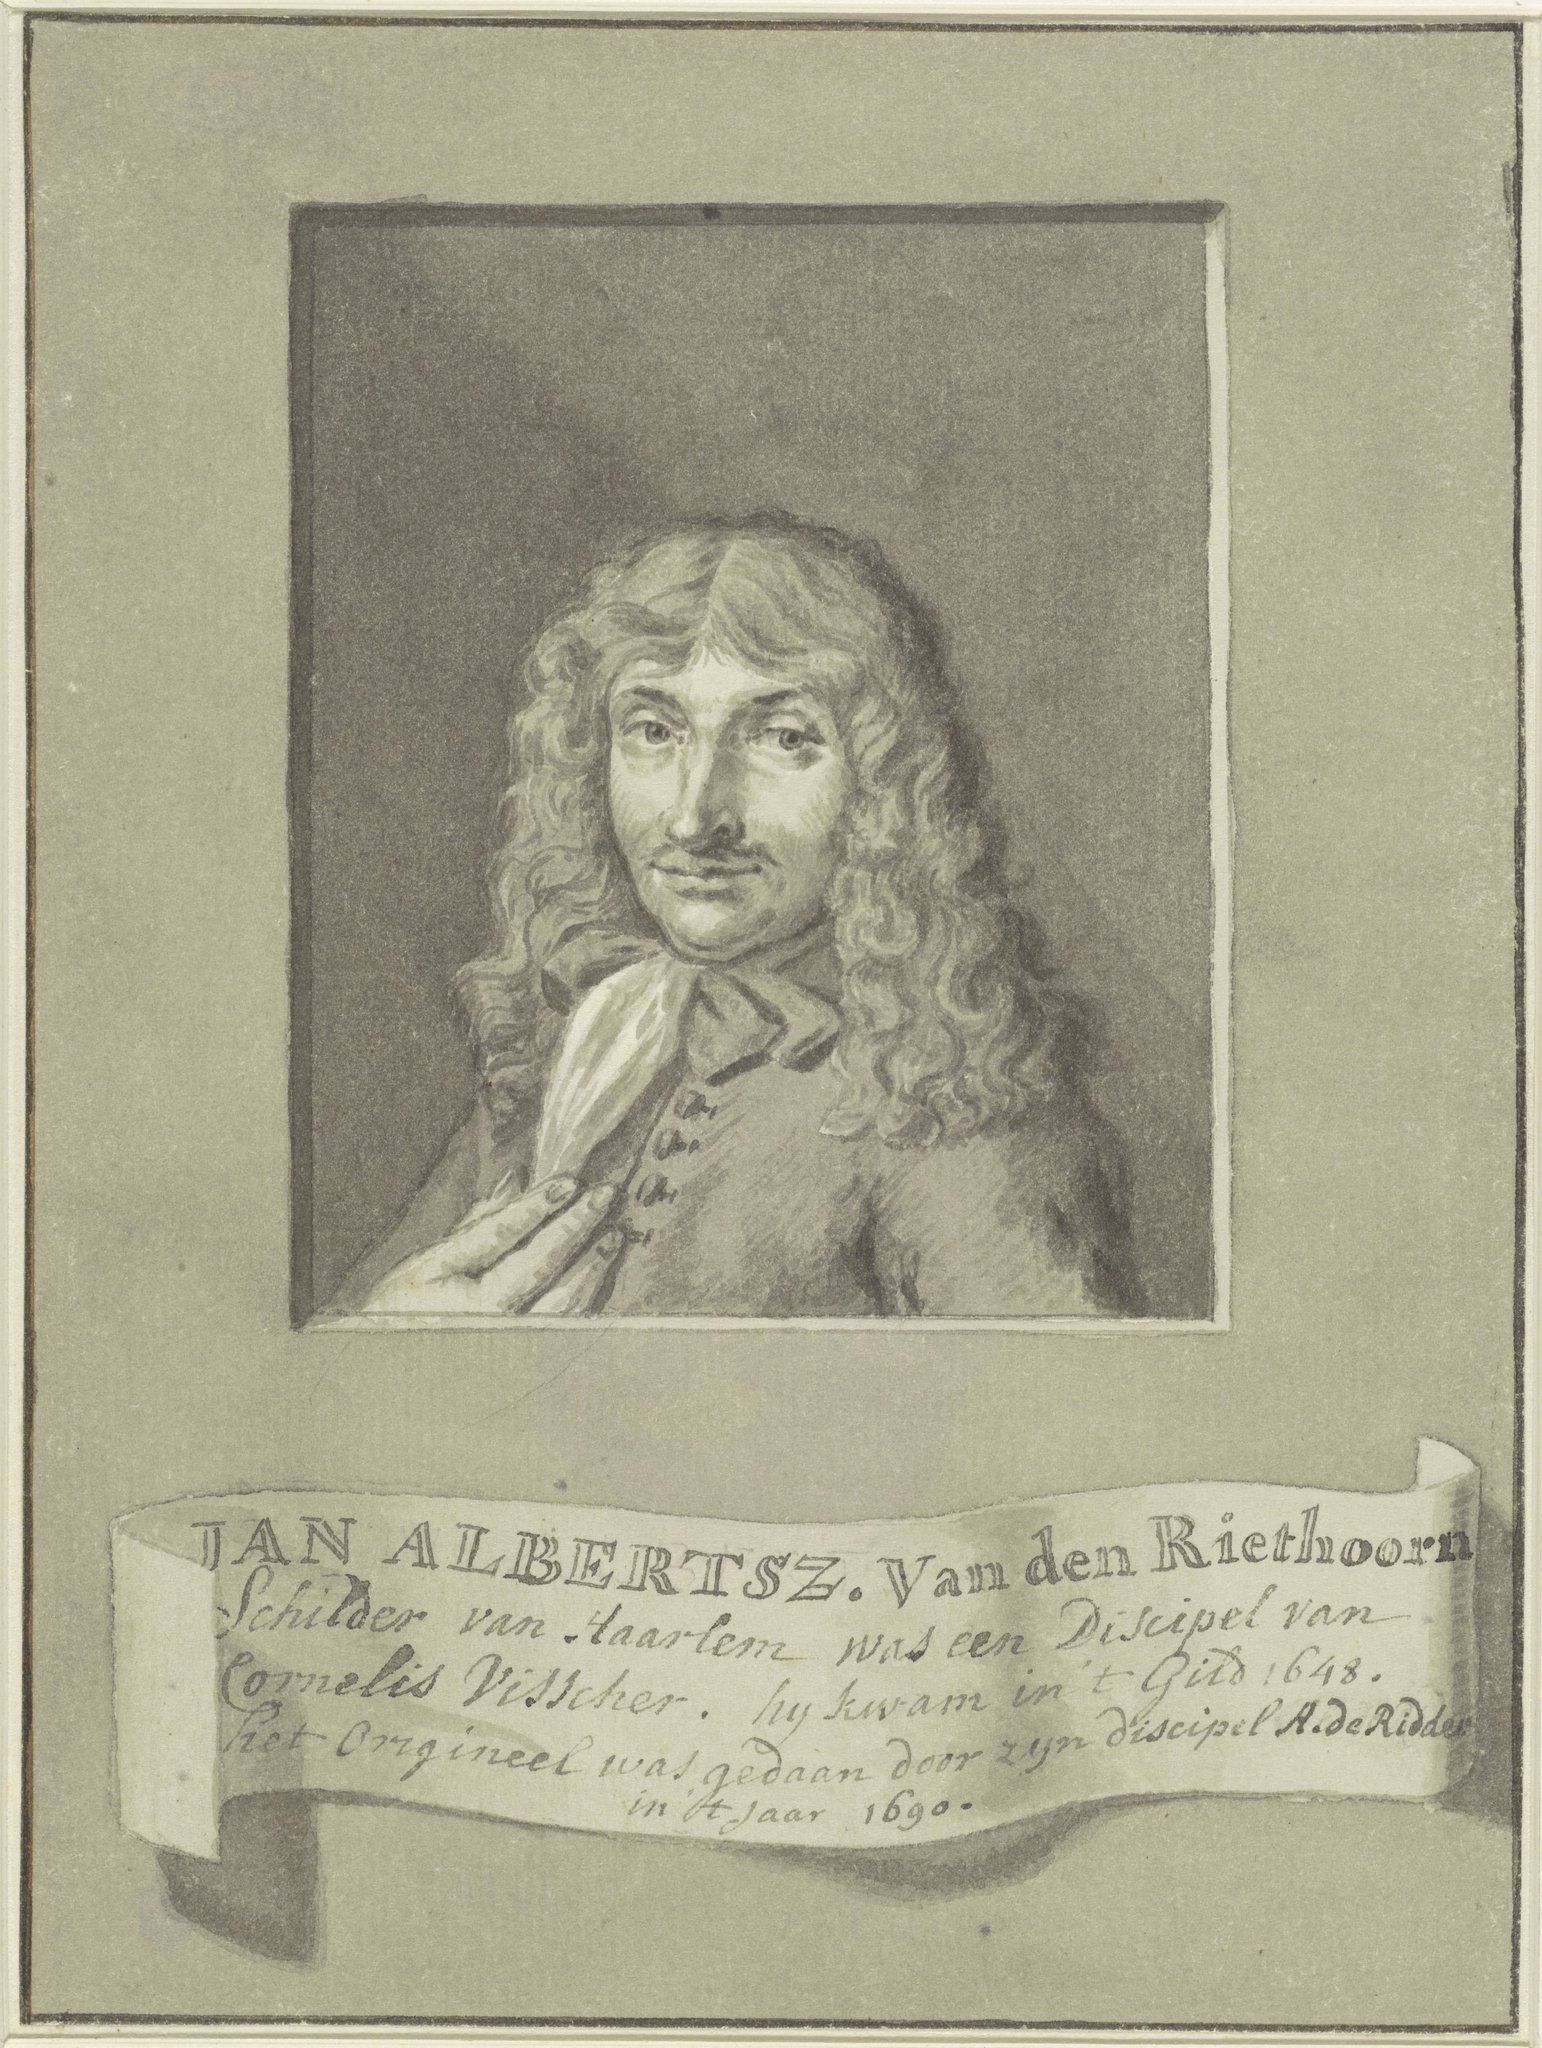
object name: drawing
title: Portret van Jan Albert van den Riethoorn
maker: Anonymous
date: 1678-1788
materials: ink, paper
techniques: pen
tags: haarlem, historical persons, portrait, self-portrait of painter, portrait, self-portrait of artist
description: Portret van de schilder Jan Albert van den Riethoorn.